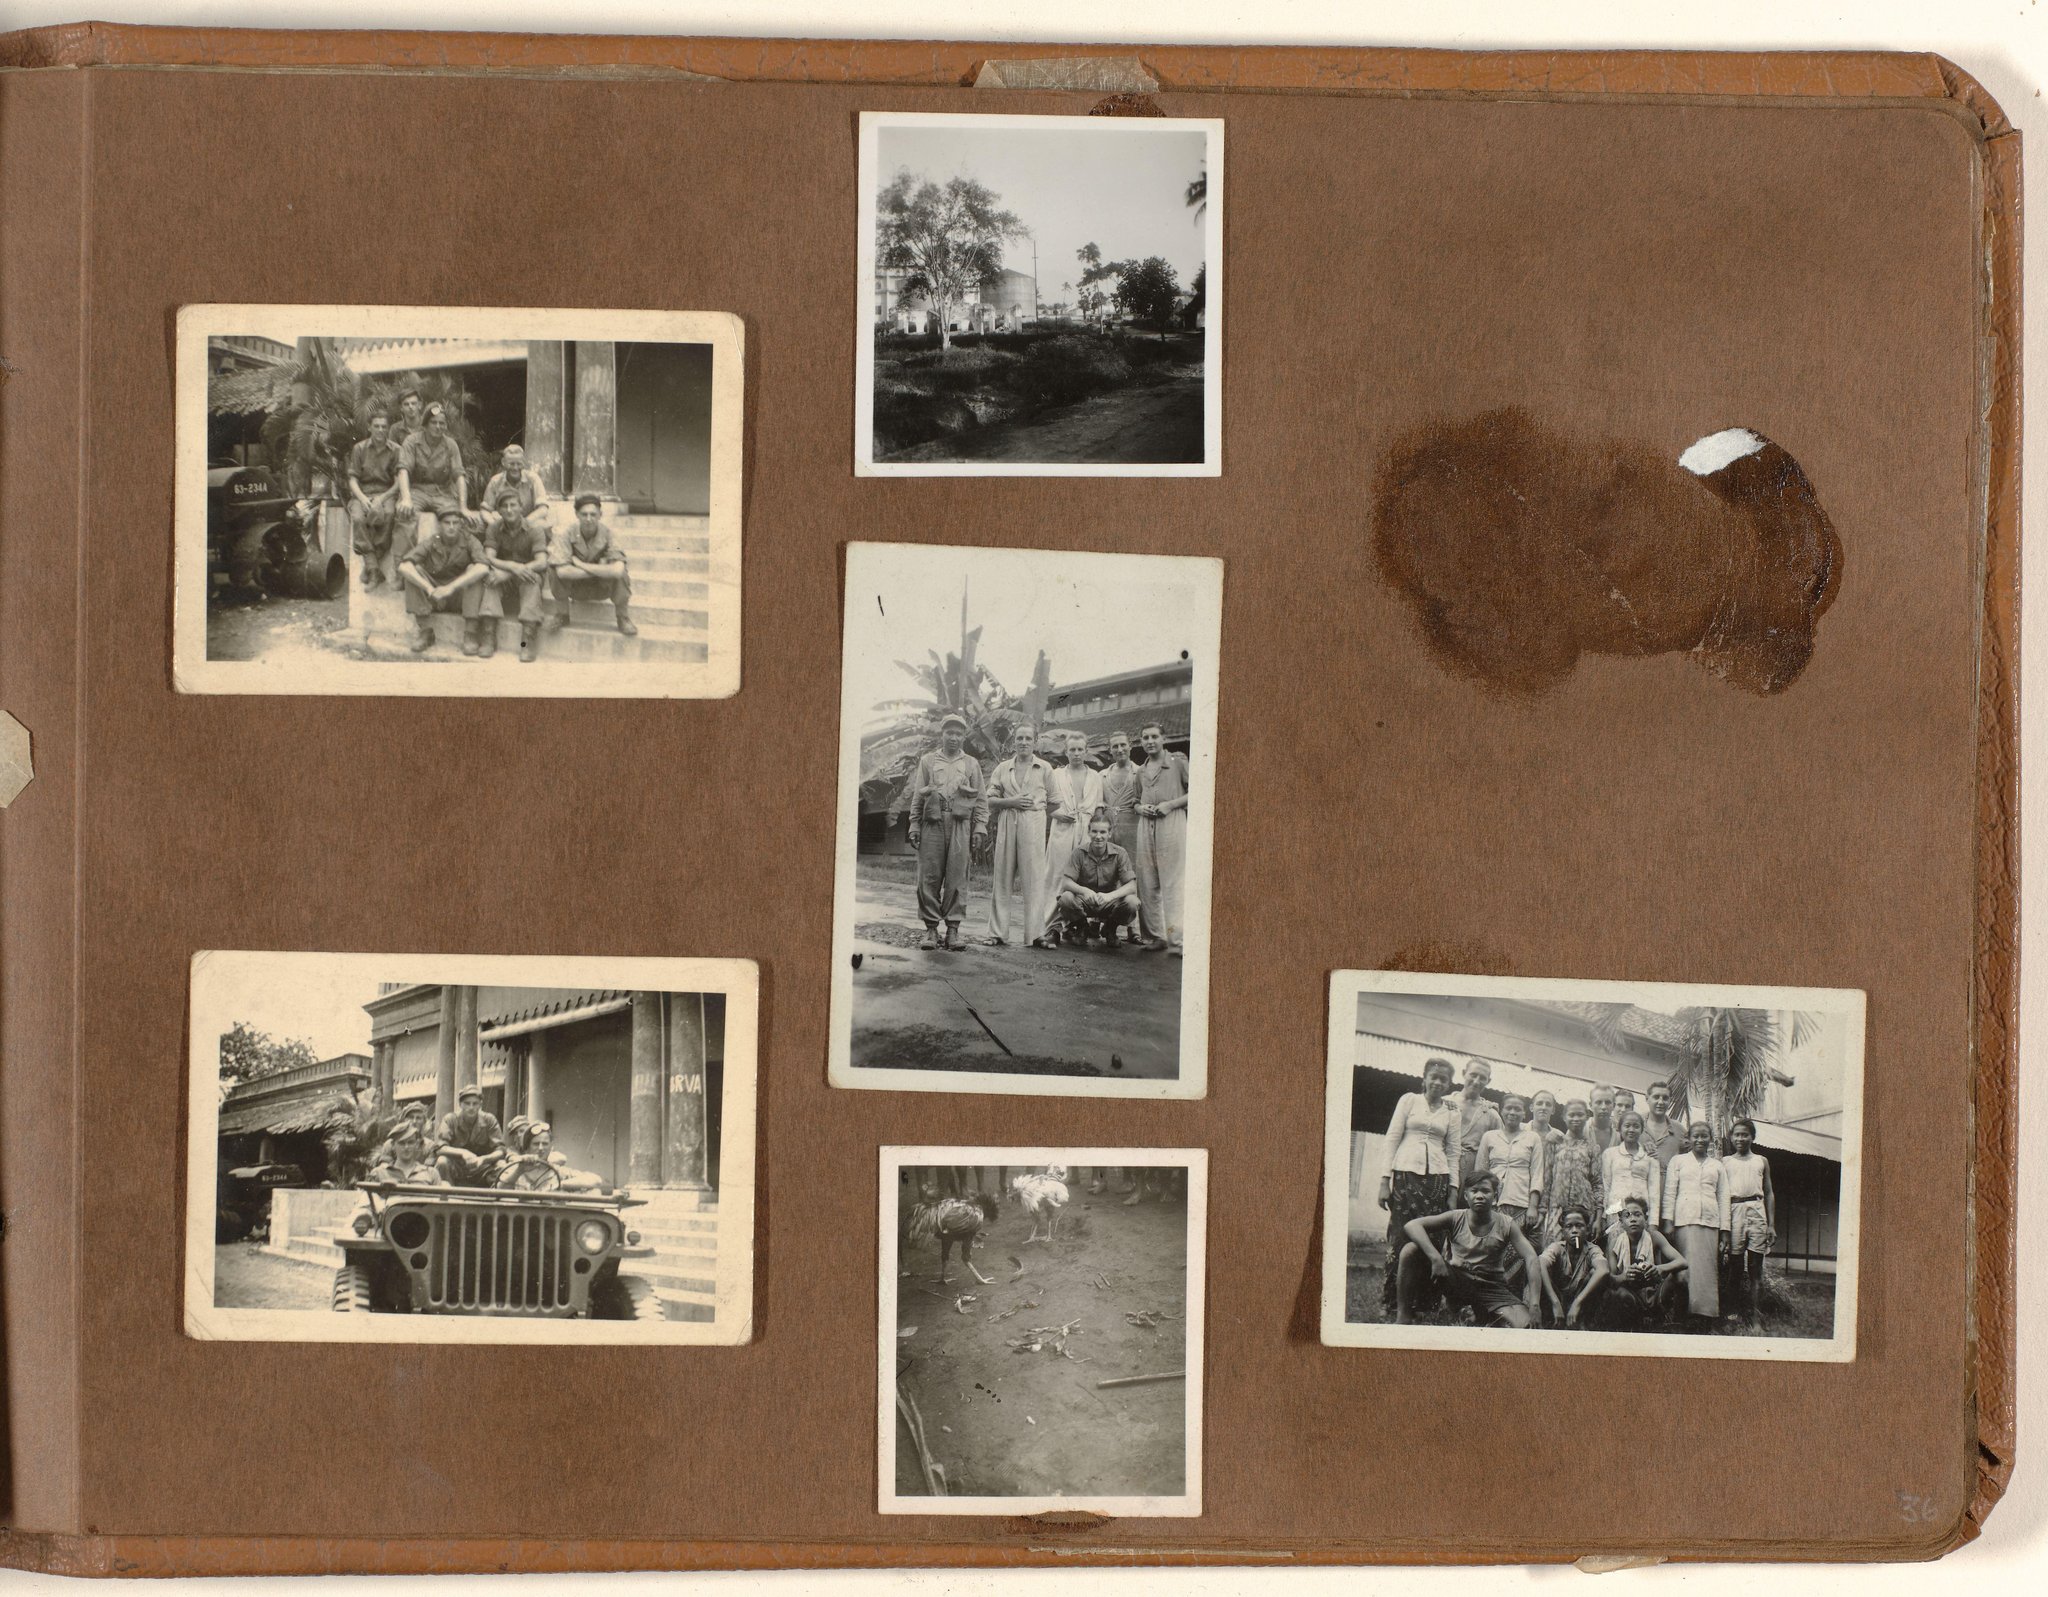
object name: album leaf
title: Soldaten met dienstpersoneel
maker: Anonymous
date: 1949-1950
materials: paper, photographic support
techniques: photography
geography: jogjakarta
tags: the company, the unit, the troop ~ military service, cock-fighting, dutch east indies, the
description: Albumblad met zes foto's. Vooral groepsfoto's van de soldaten van het vijfde Regiment Infanterie, waaronder een groepsfoto van een aantal soldaten die samen met het Javaanse dienstpersoneel poseert. Verder ook een hanengevecht en de restanten van een gebouw. Waarschijnlijk in het district Wonosari.